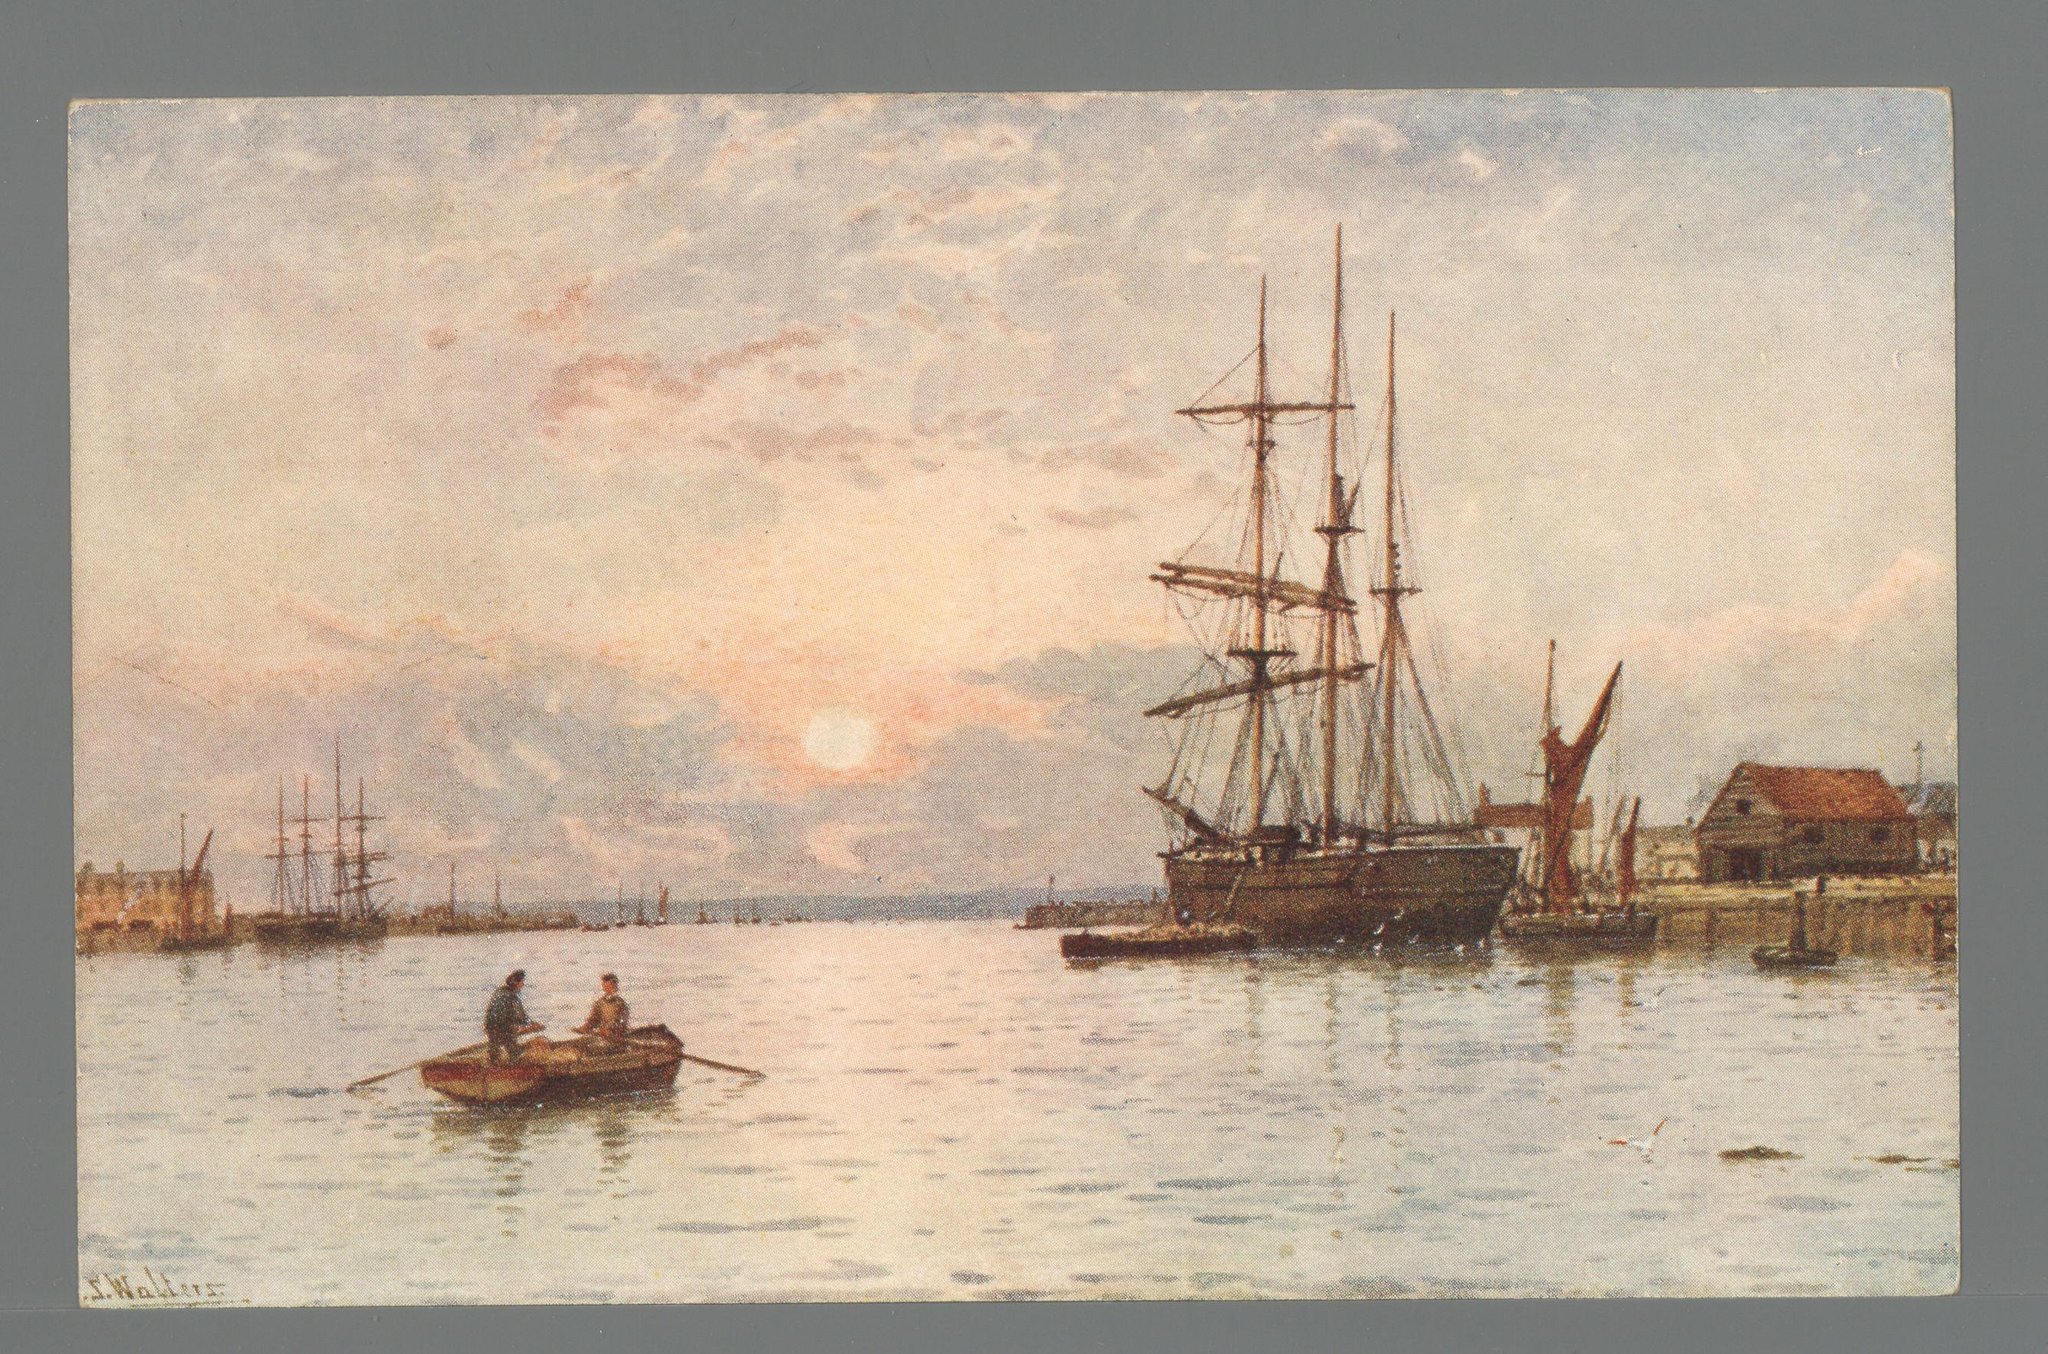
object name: photomechanical print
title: "Sunrise," Poole Harbour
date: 1905-1930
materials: cardboard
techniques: color autotype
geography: london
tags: harbour, ships (in general), sunrise